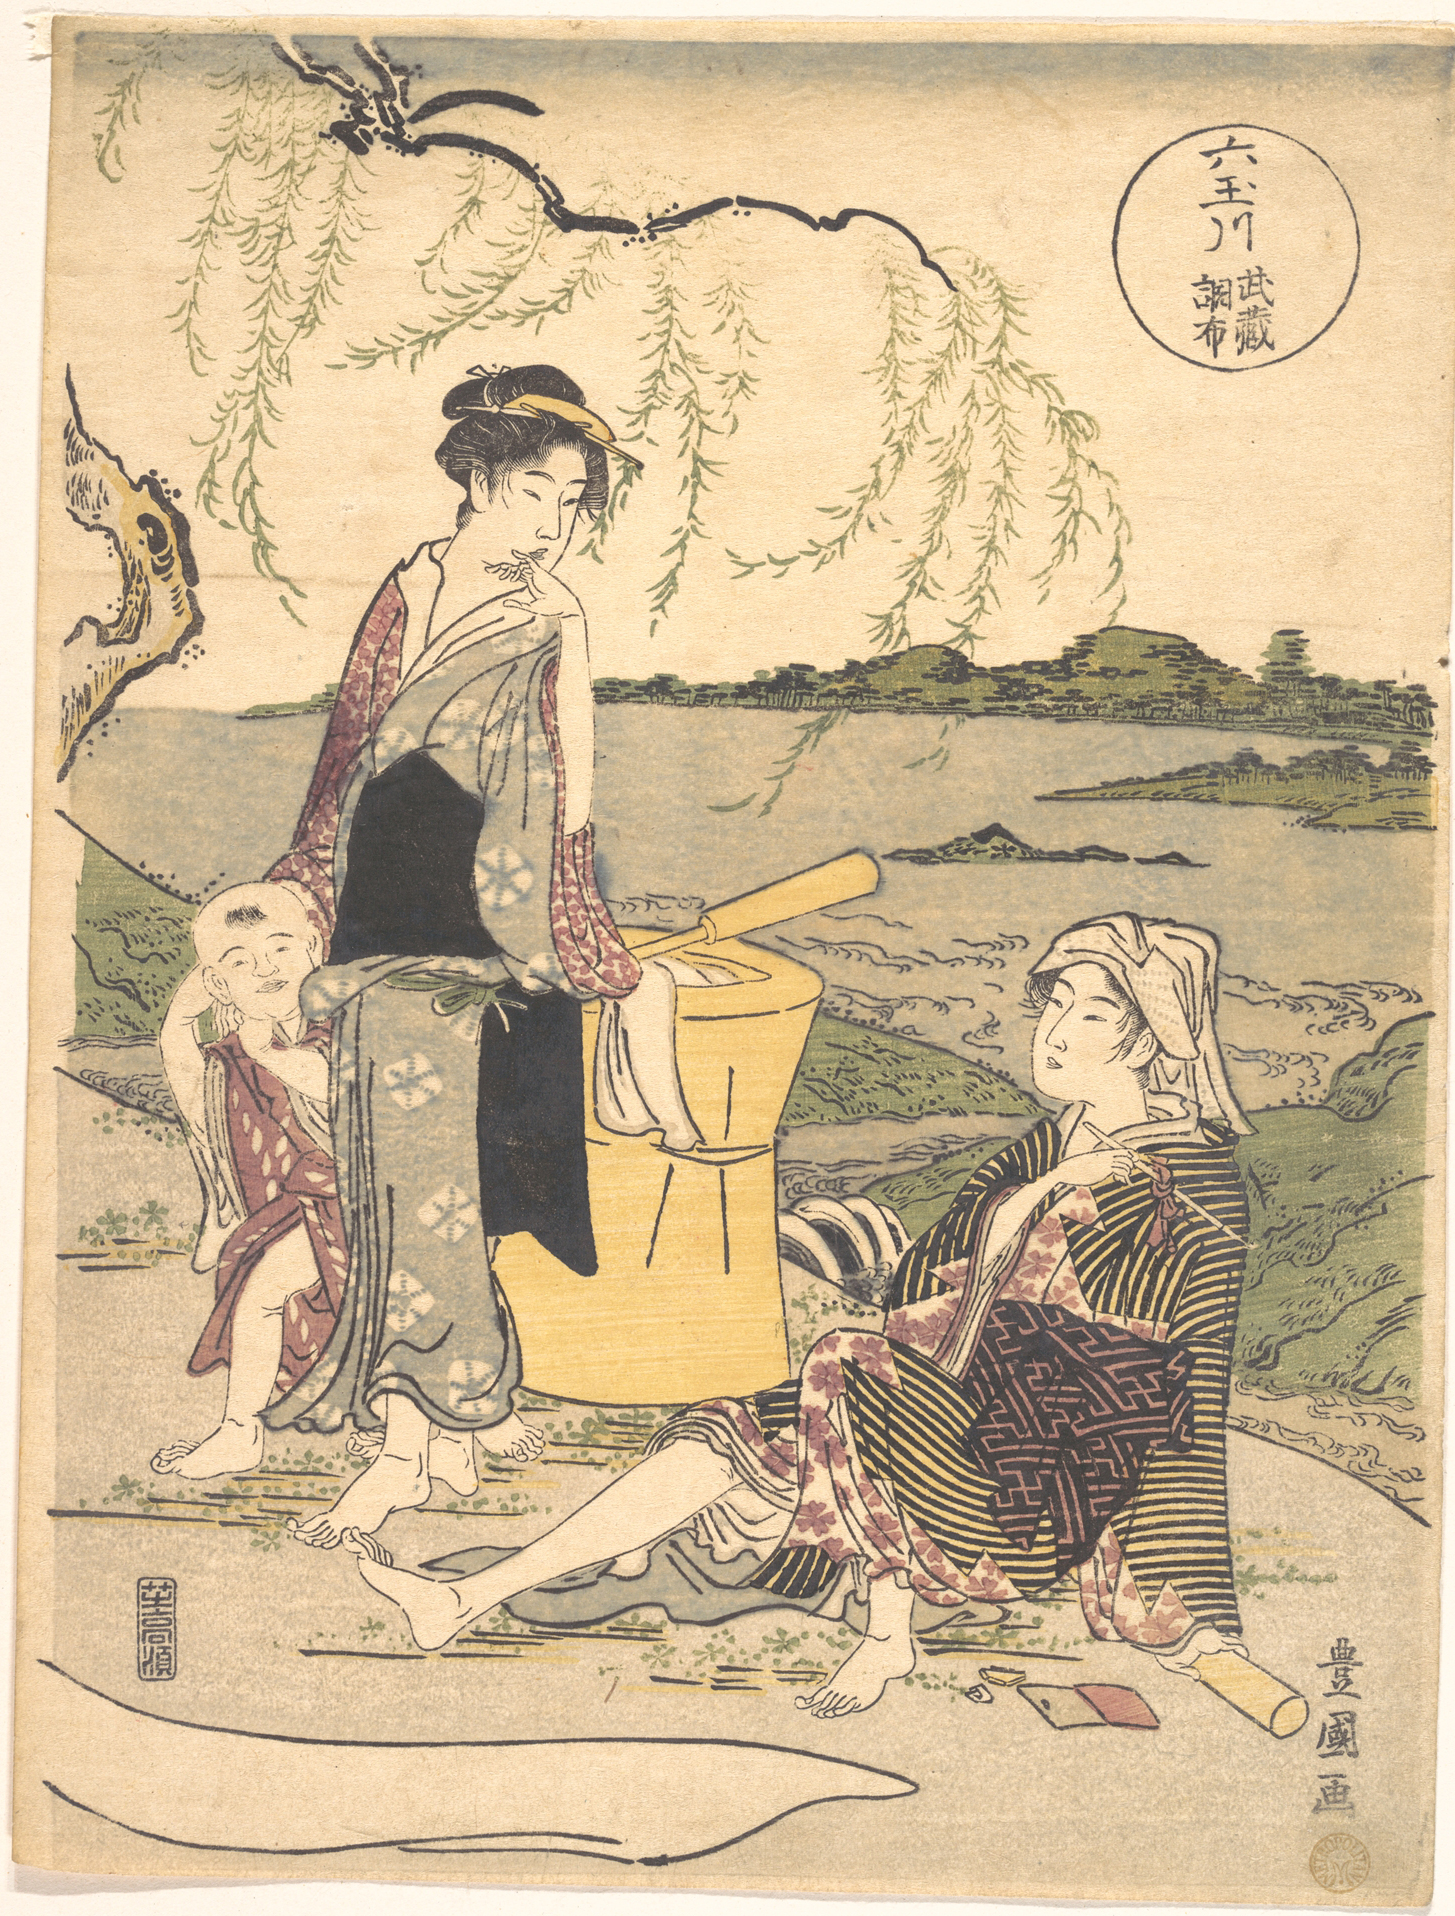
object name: print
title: Chofu no Tamagawa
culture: japanese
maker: utagawa toyokuni i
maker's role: artist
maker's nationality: japanese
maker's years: 1769-1825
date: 1789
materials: ink, paper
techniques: woodblock print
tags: children,women,trees